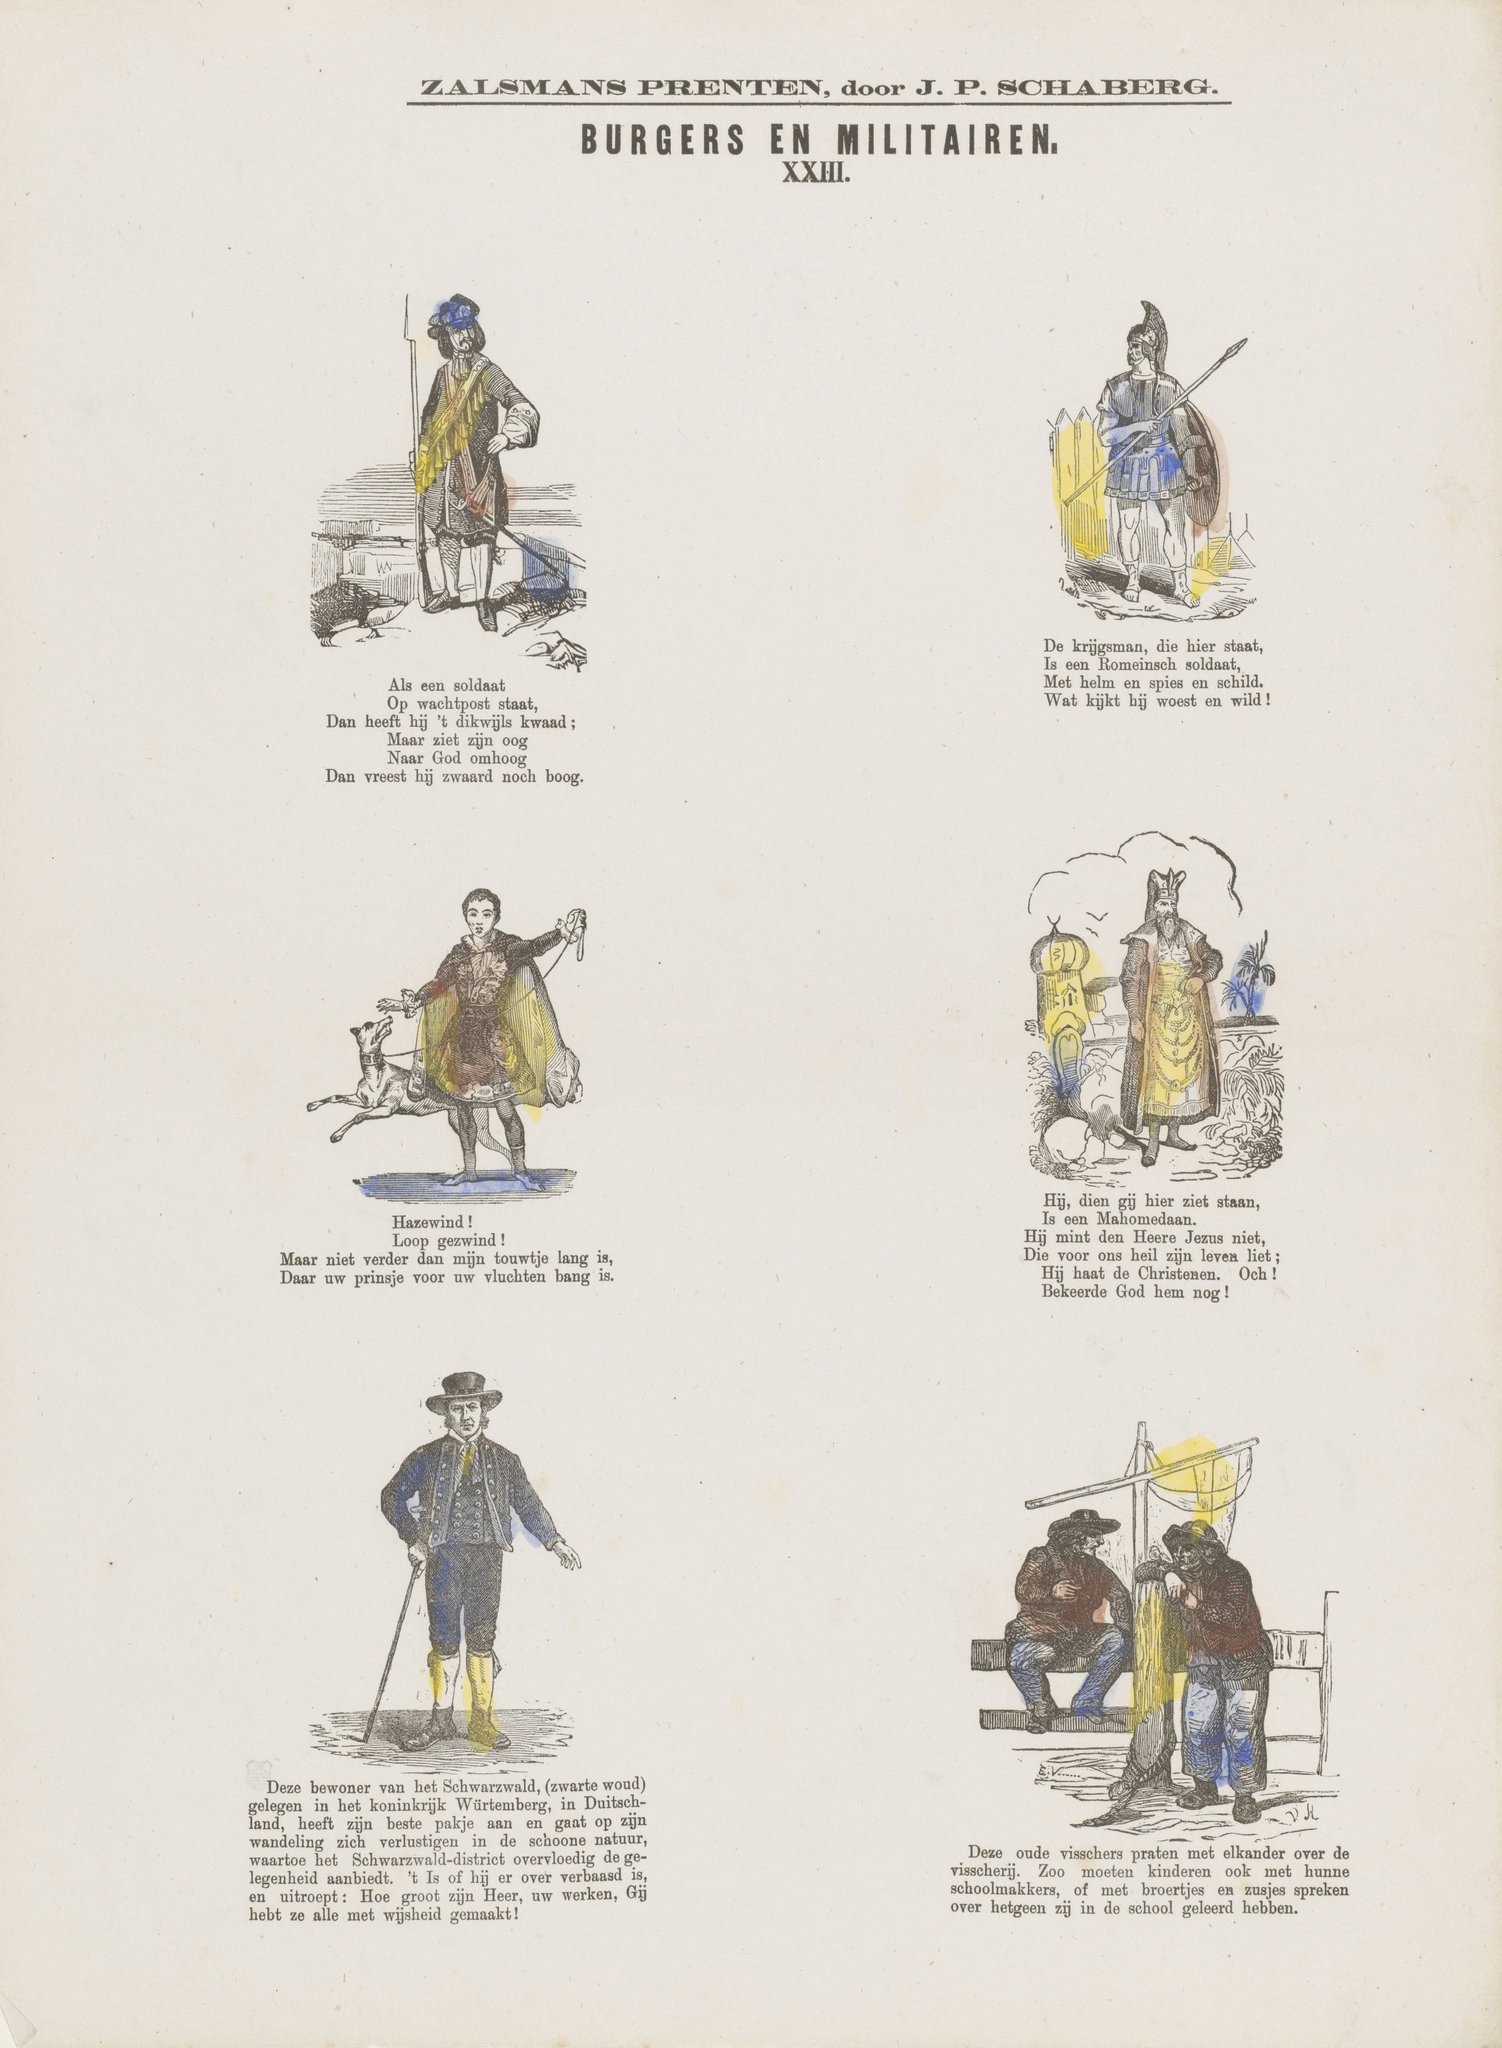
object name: print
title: Zalmans prenten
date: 1869-1882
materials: paper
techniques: colour, letterpress printing, engraving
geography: europe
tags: human types, prince, characters (human types), the soldier; the soldier's life, fisherman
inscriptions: collector's mark: Lugt 2760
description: Blad met 6 voorstellingen van verschillende figuren, zoals een soldaat, een prins en een moslim. Onder elke afbeelding een onderschrift. Genummerd midden boven: XXIII.